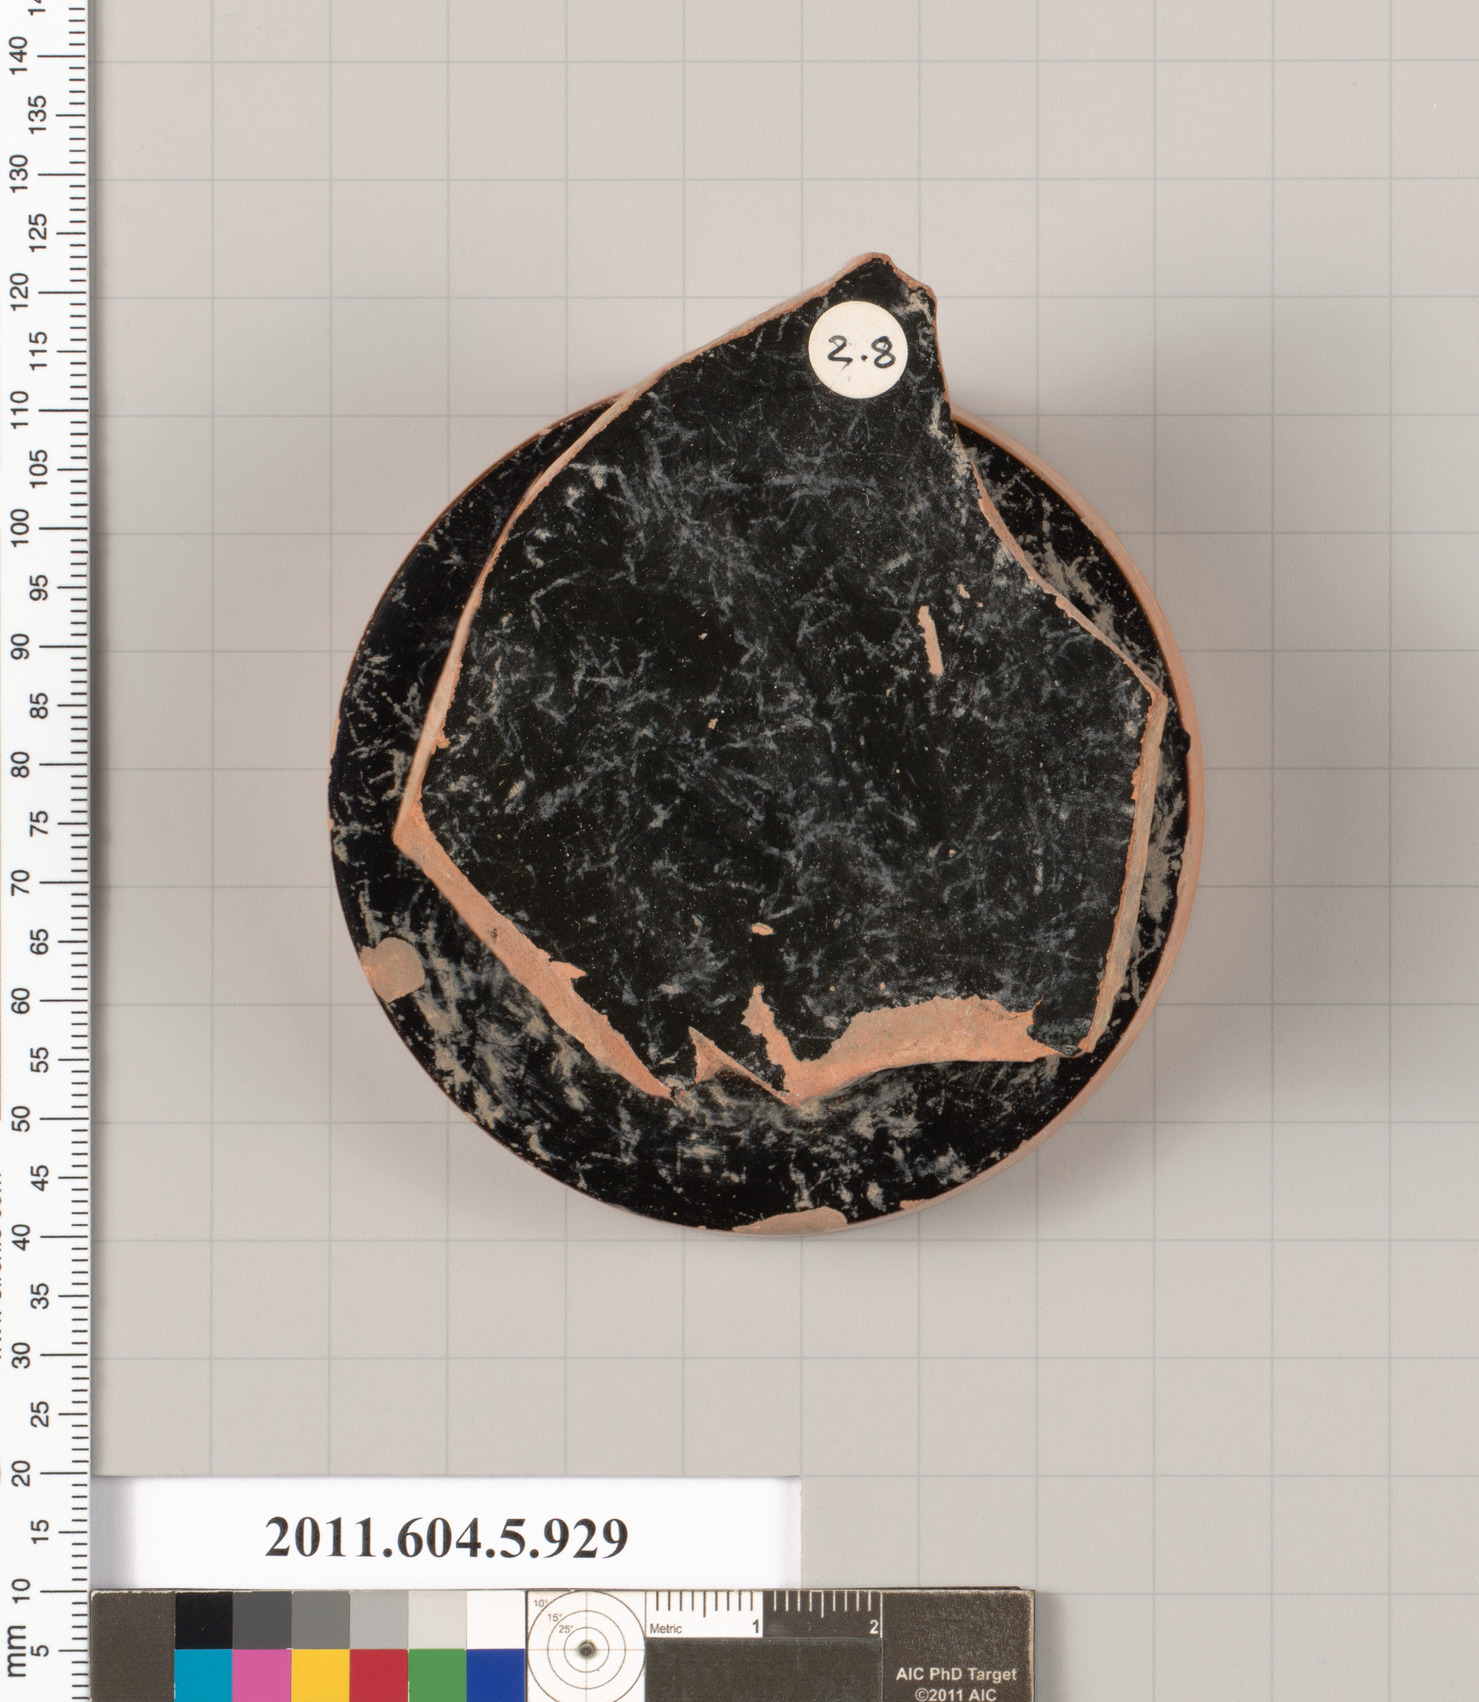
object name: kylix fragment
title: Terracotta fragment of a kylix (drinking cup)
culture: greek, attic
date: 600-401 BCE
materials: terracotta